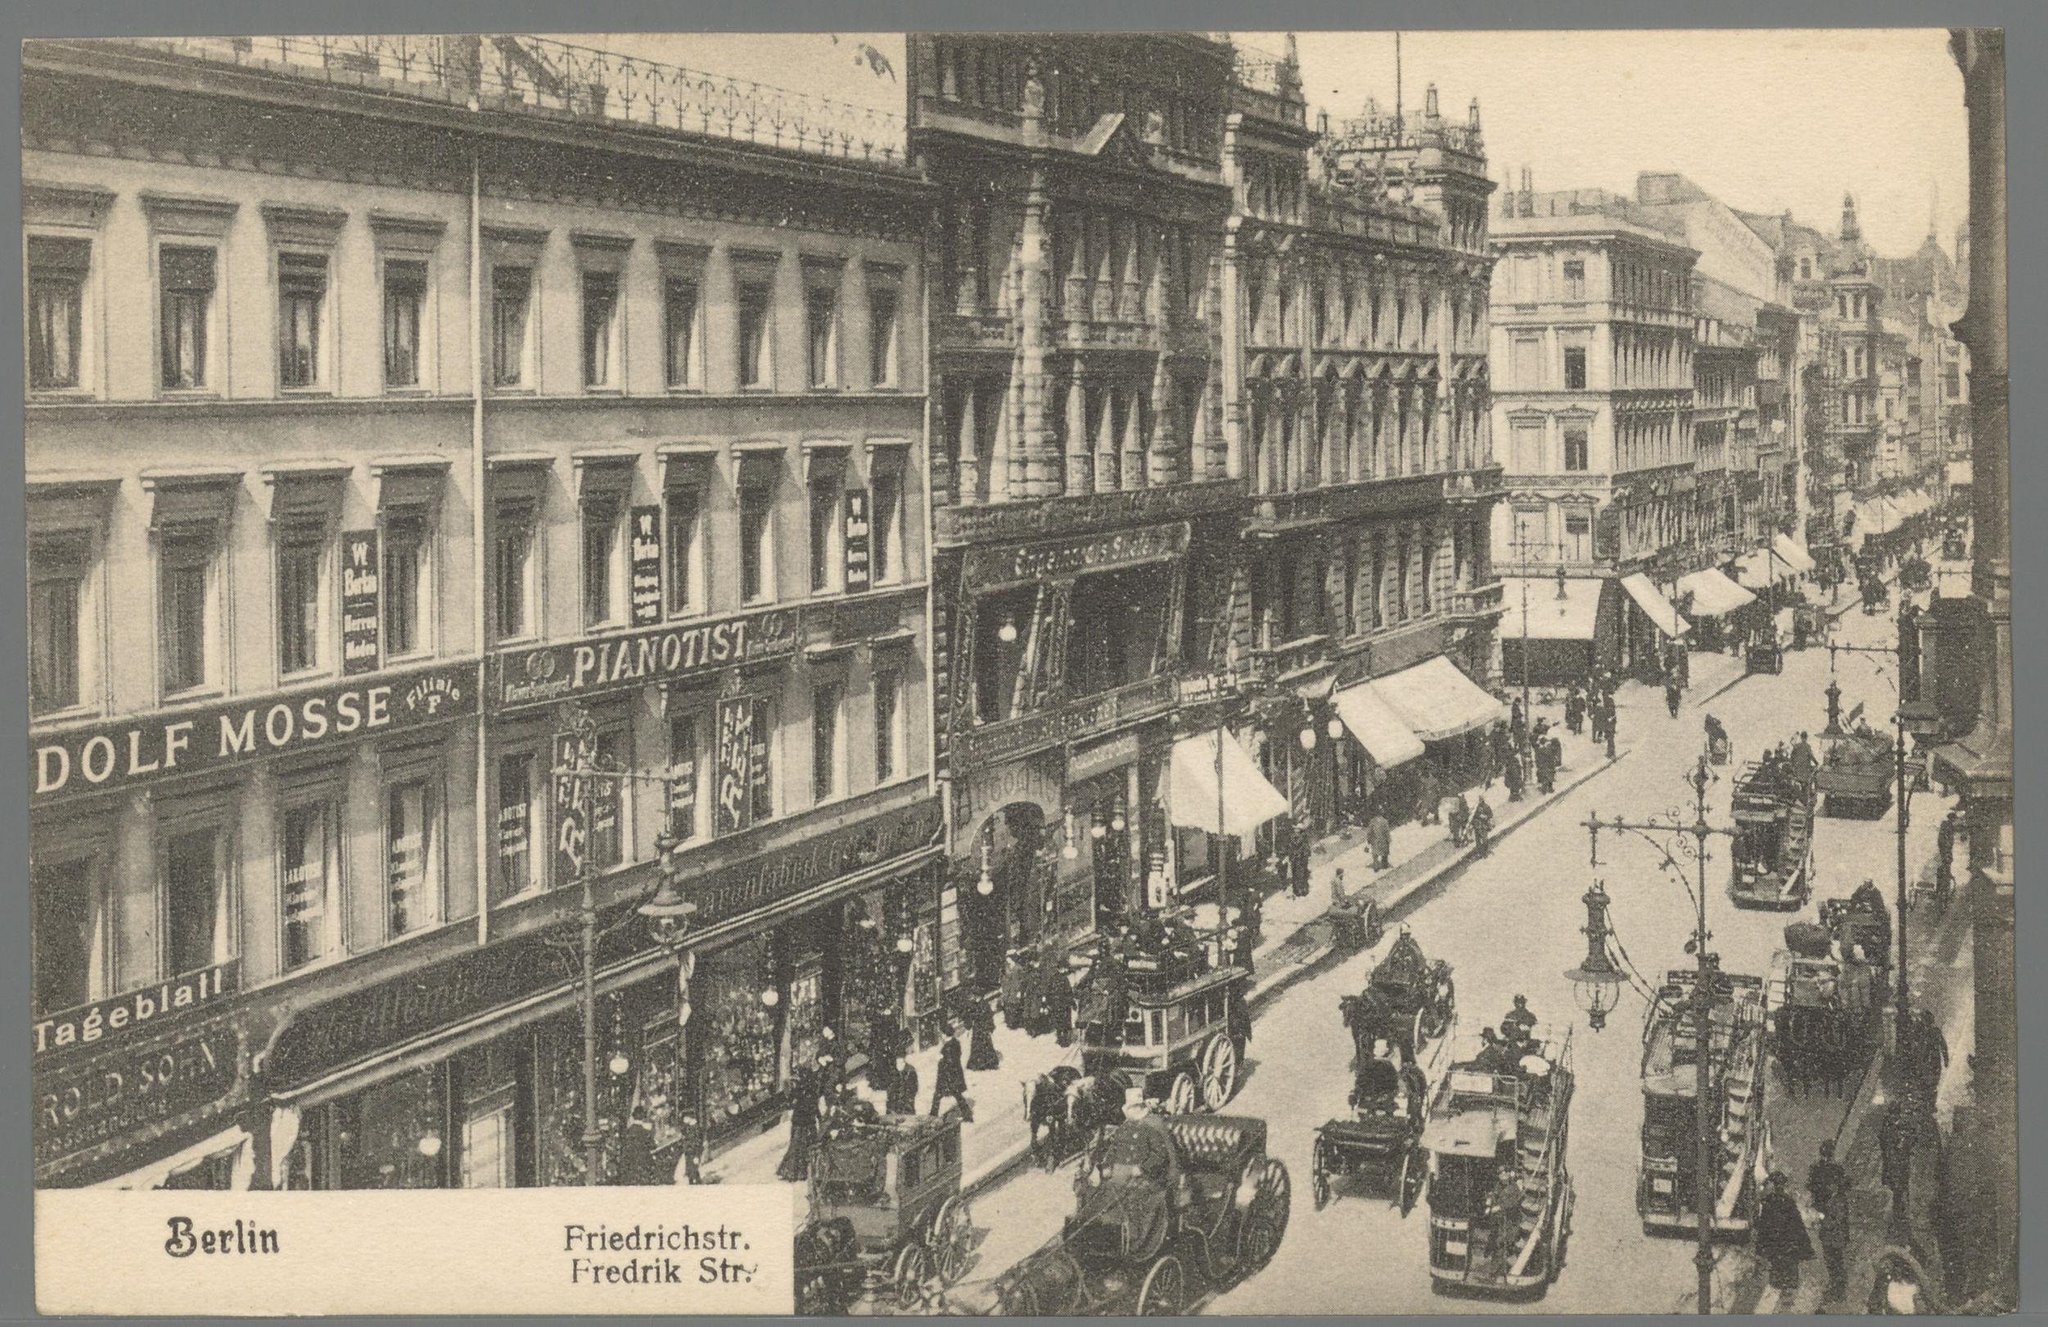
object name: ansichtkaart, prentbriefkaart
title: Berlin. Friedrichstr. / Fredrik Str.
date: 1905-1930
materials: cardboard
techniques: rotogravure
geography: berlin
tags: shop, store, street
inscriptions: stamp: ‘5’